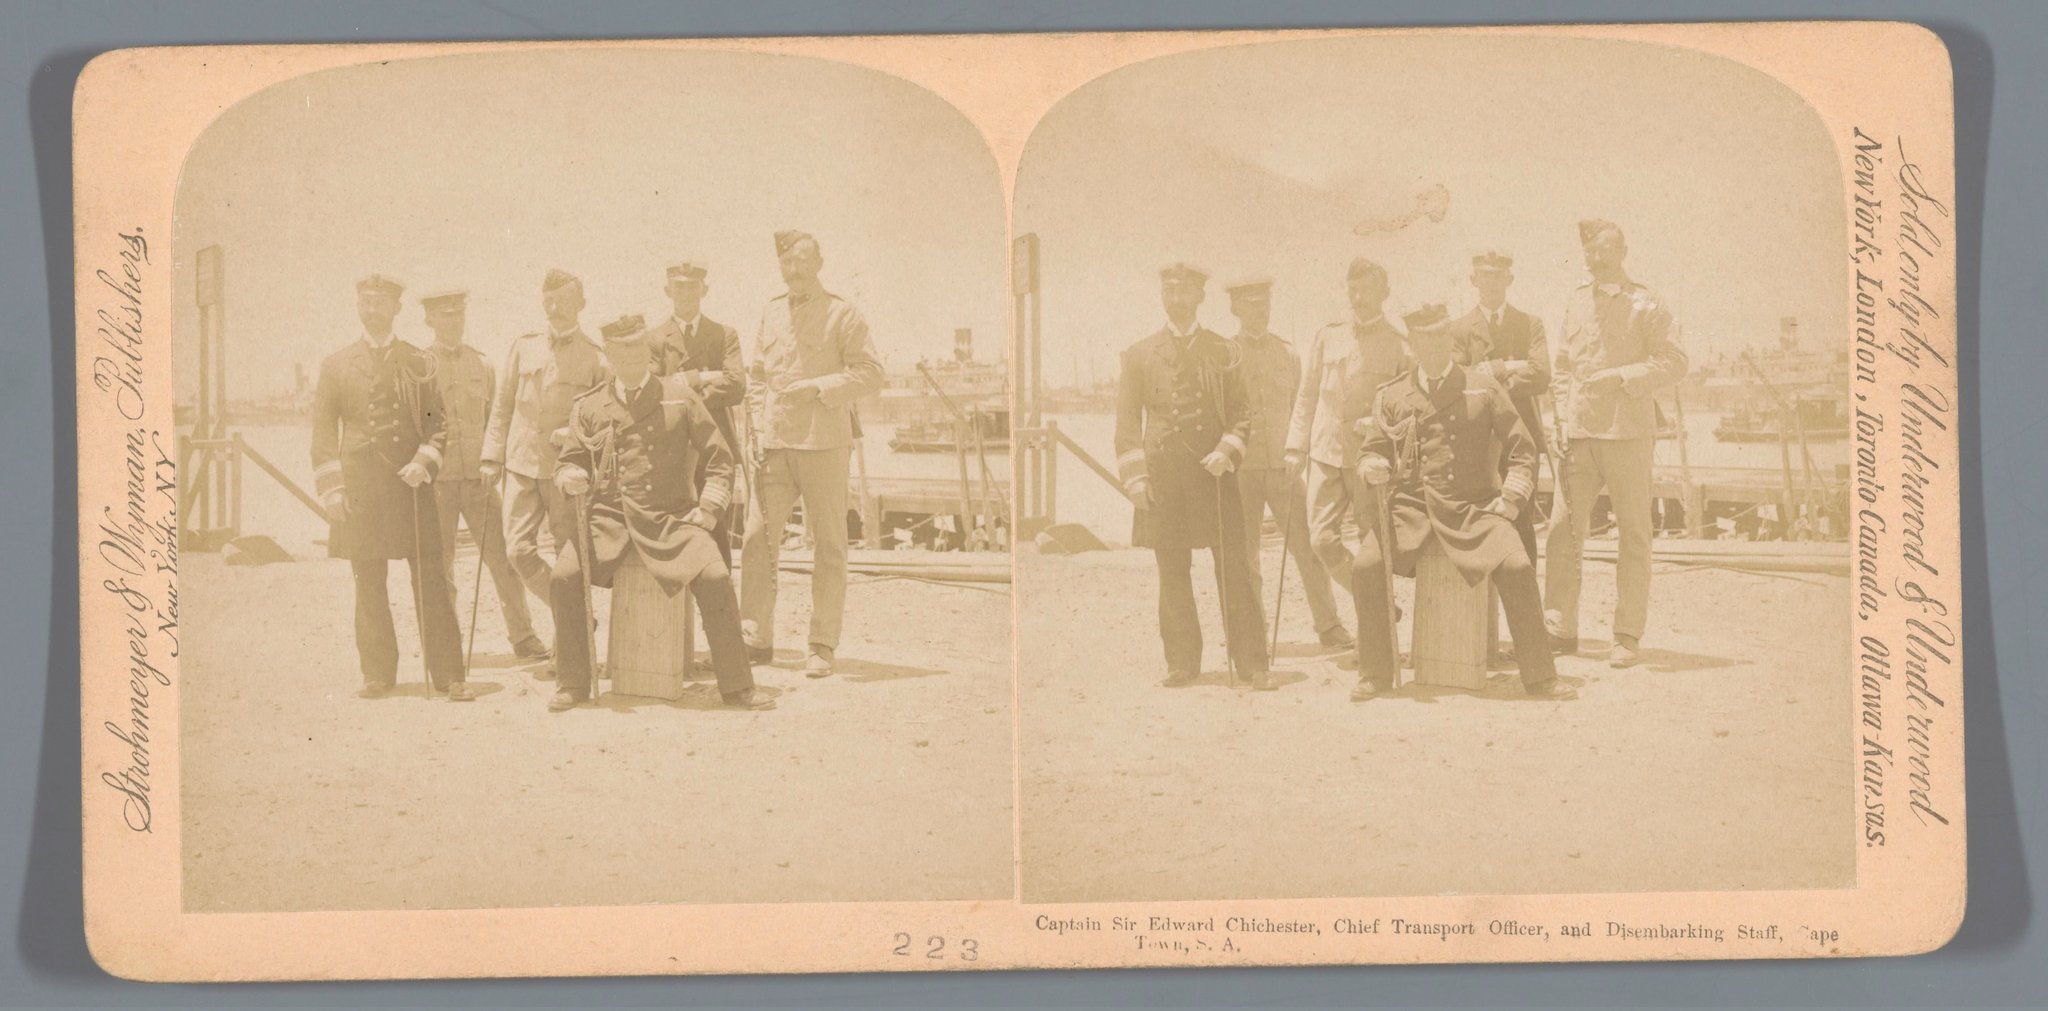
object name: stereograph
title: Captain Sir Edward Chichester, Chief Transport Officer, and Disembarking Staff, Cape Town, S.A.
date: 1900-1905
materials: cardboard, photographic support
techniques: albumen print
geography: new york city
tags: commander-in-chief, admiral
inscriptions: number: ‘223’